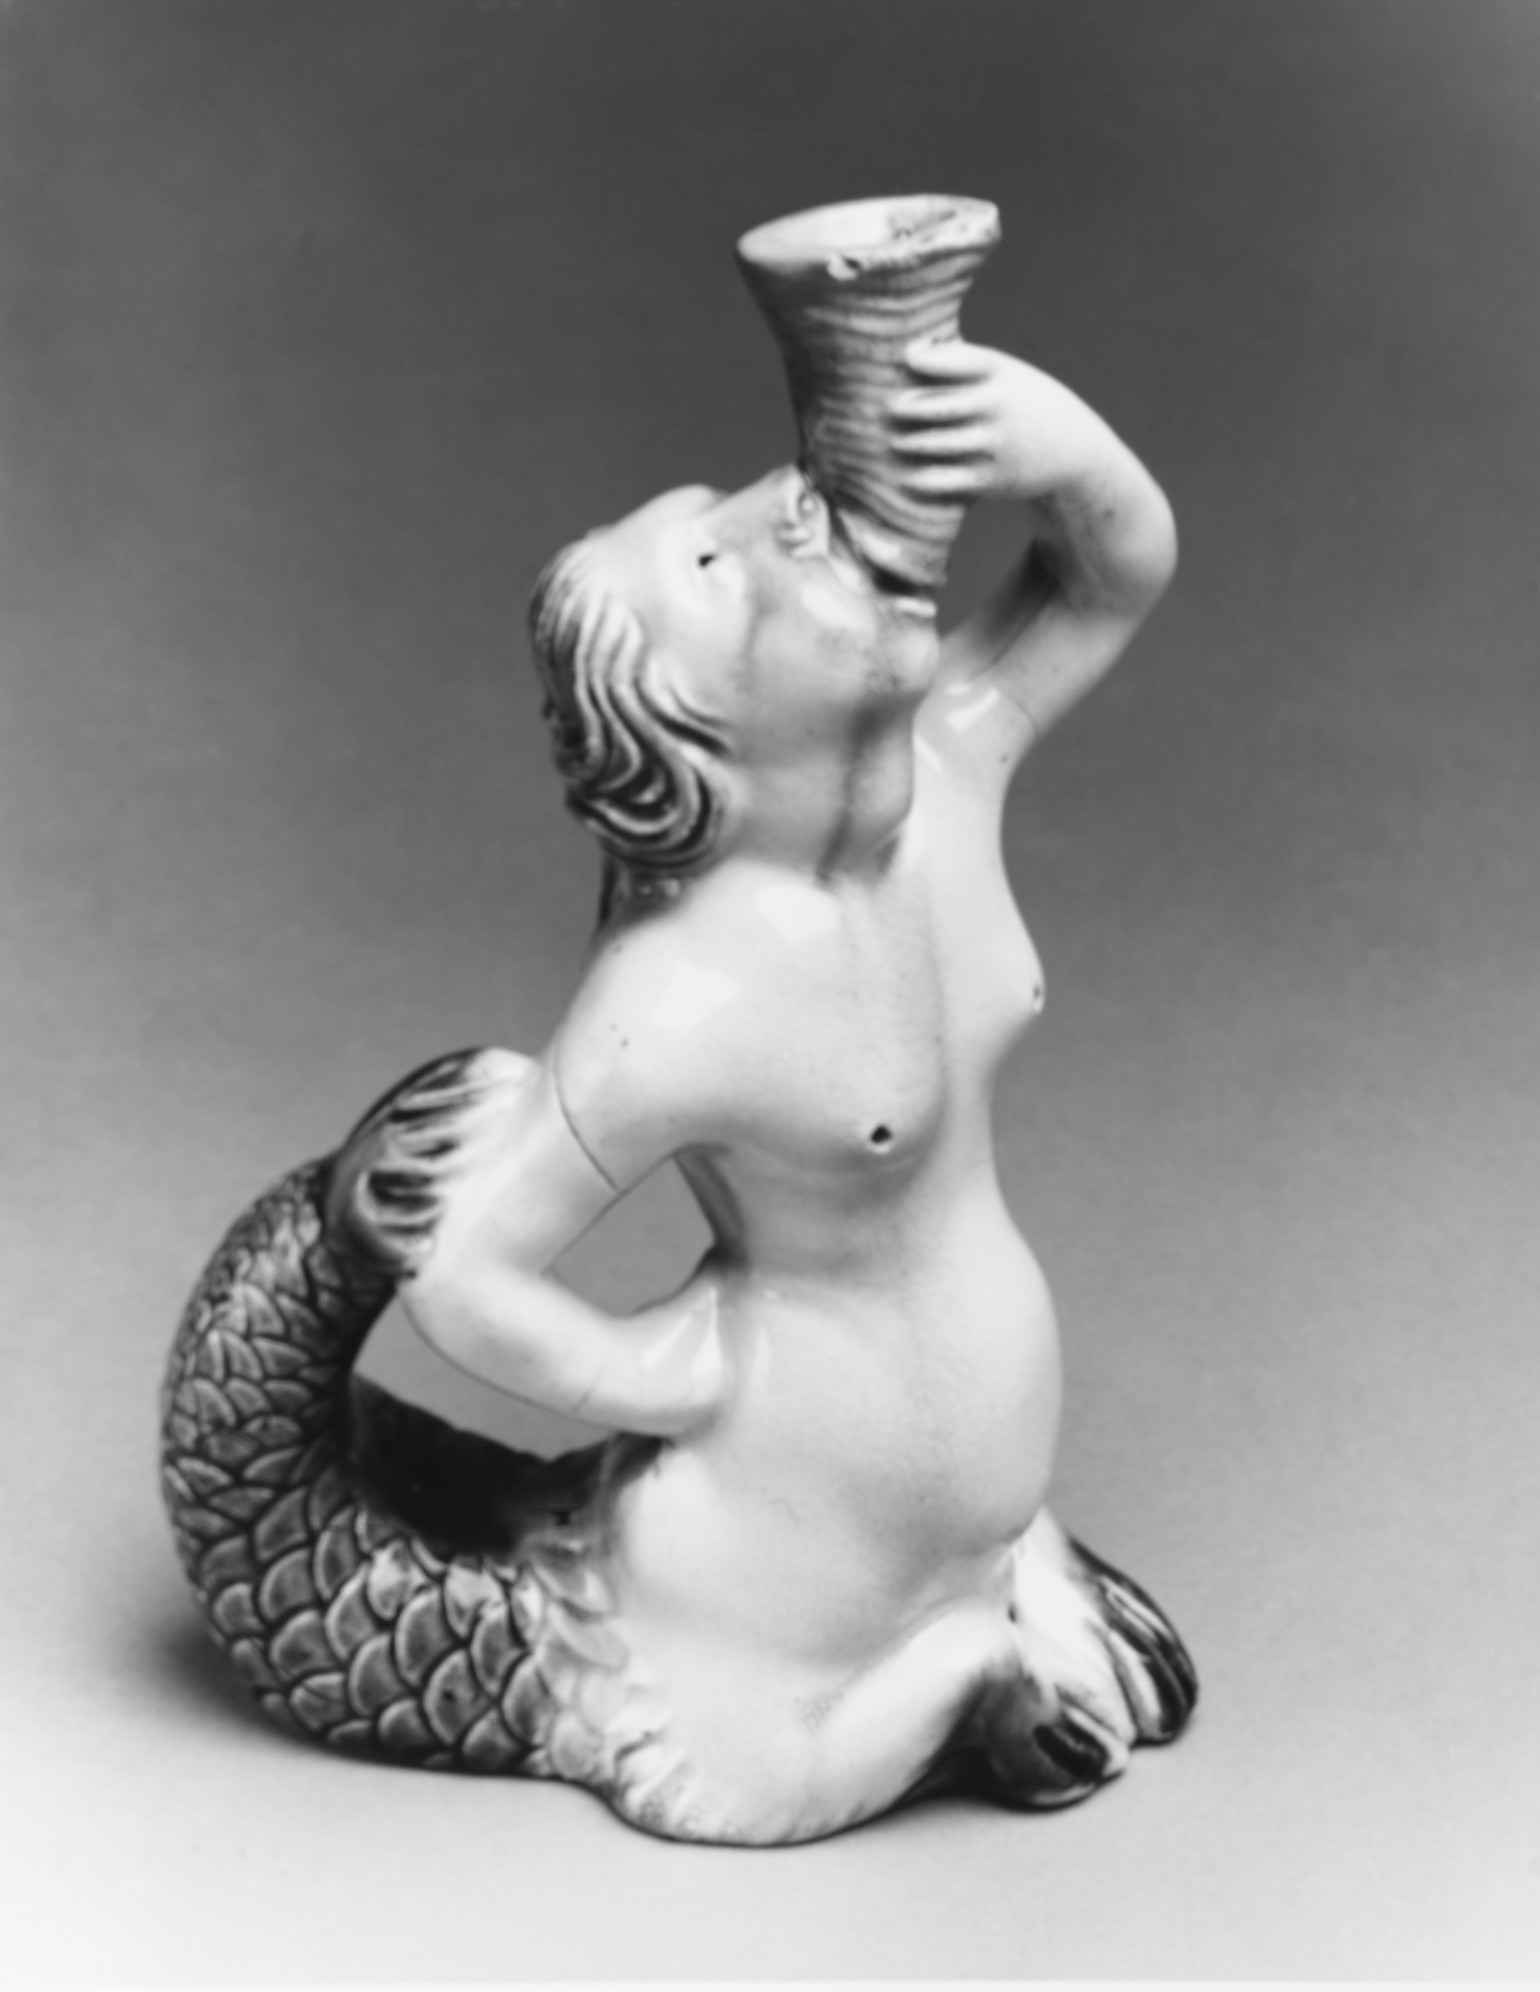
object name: figure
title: Figure of a Nereid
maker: bernard palissy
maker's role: maker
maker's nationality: french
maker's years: 1510-1590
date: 1600-1610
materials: earthenware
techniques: glazing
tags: mermaids,nymphs